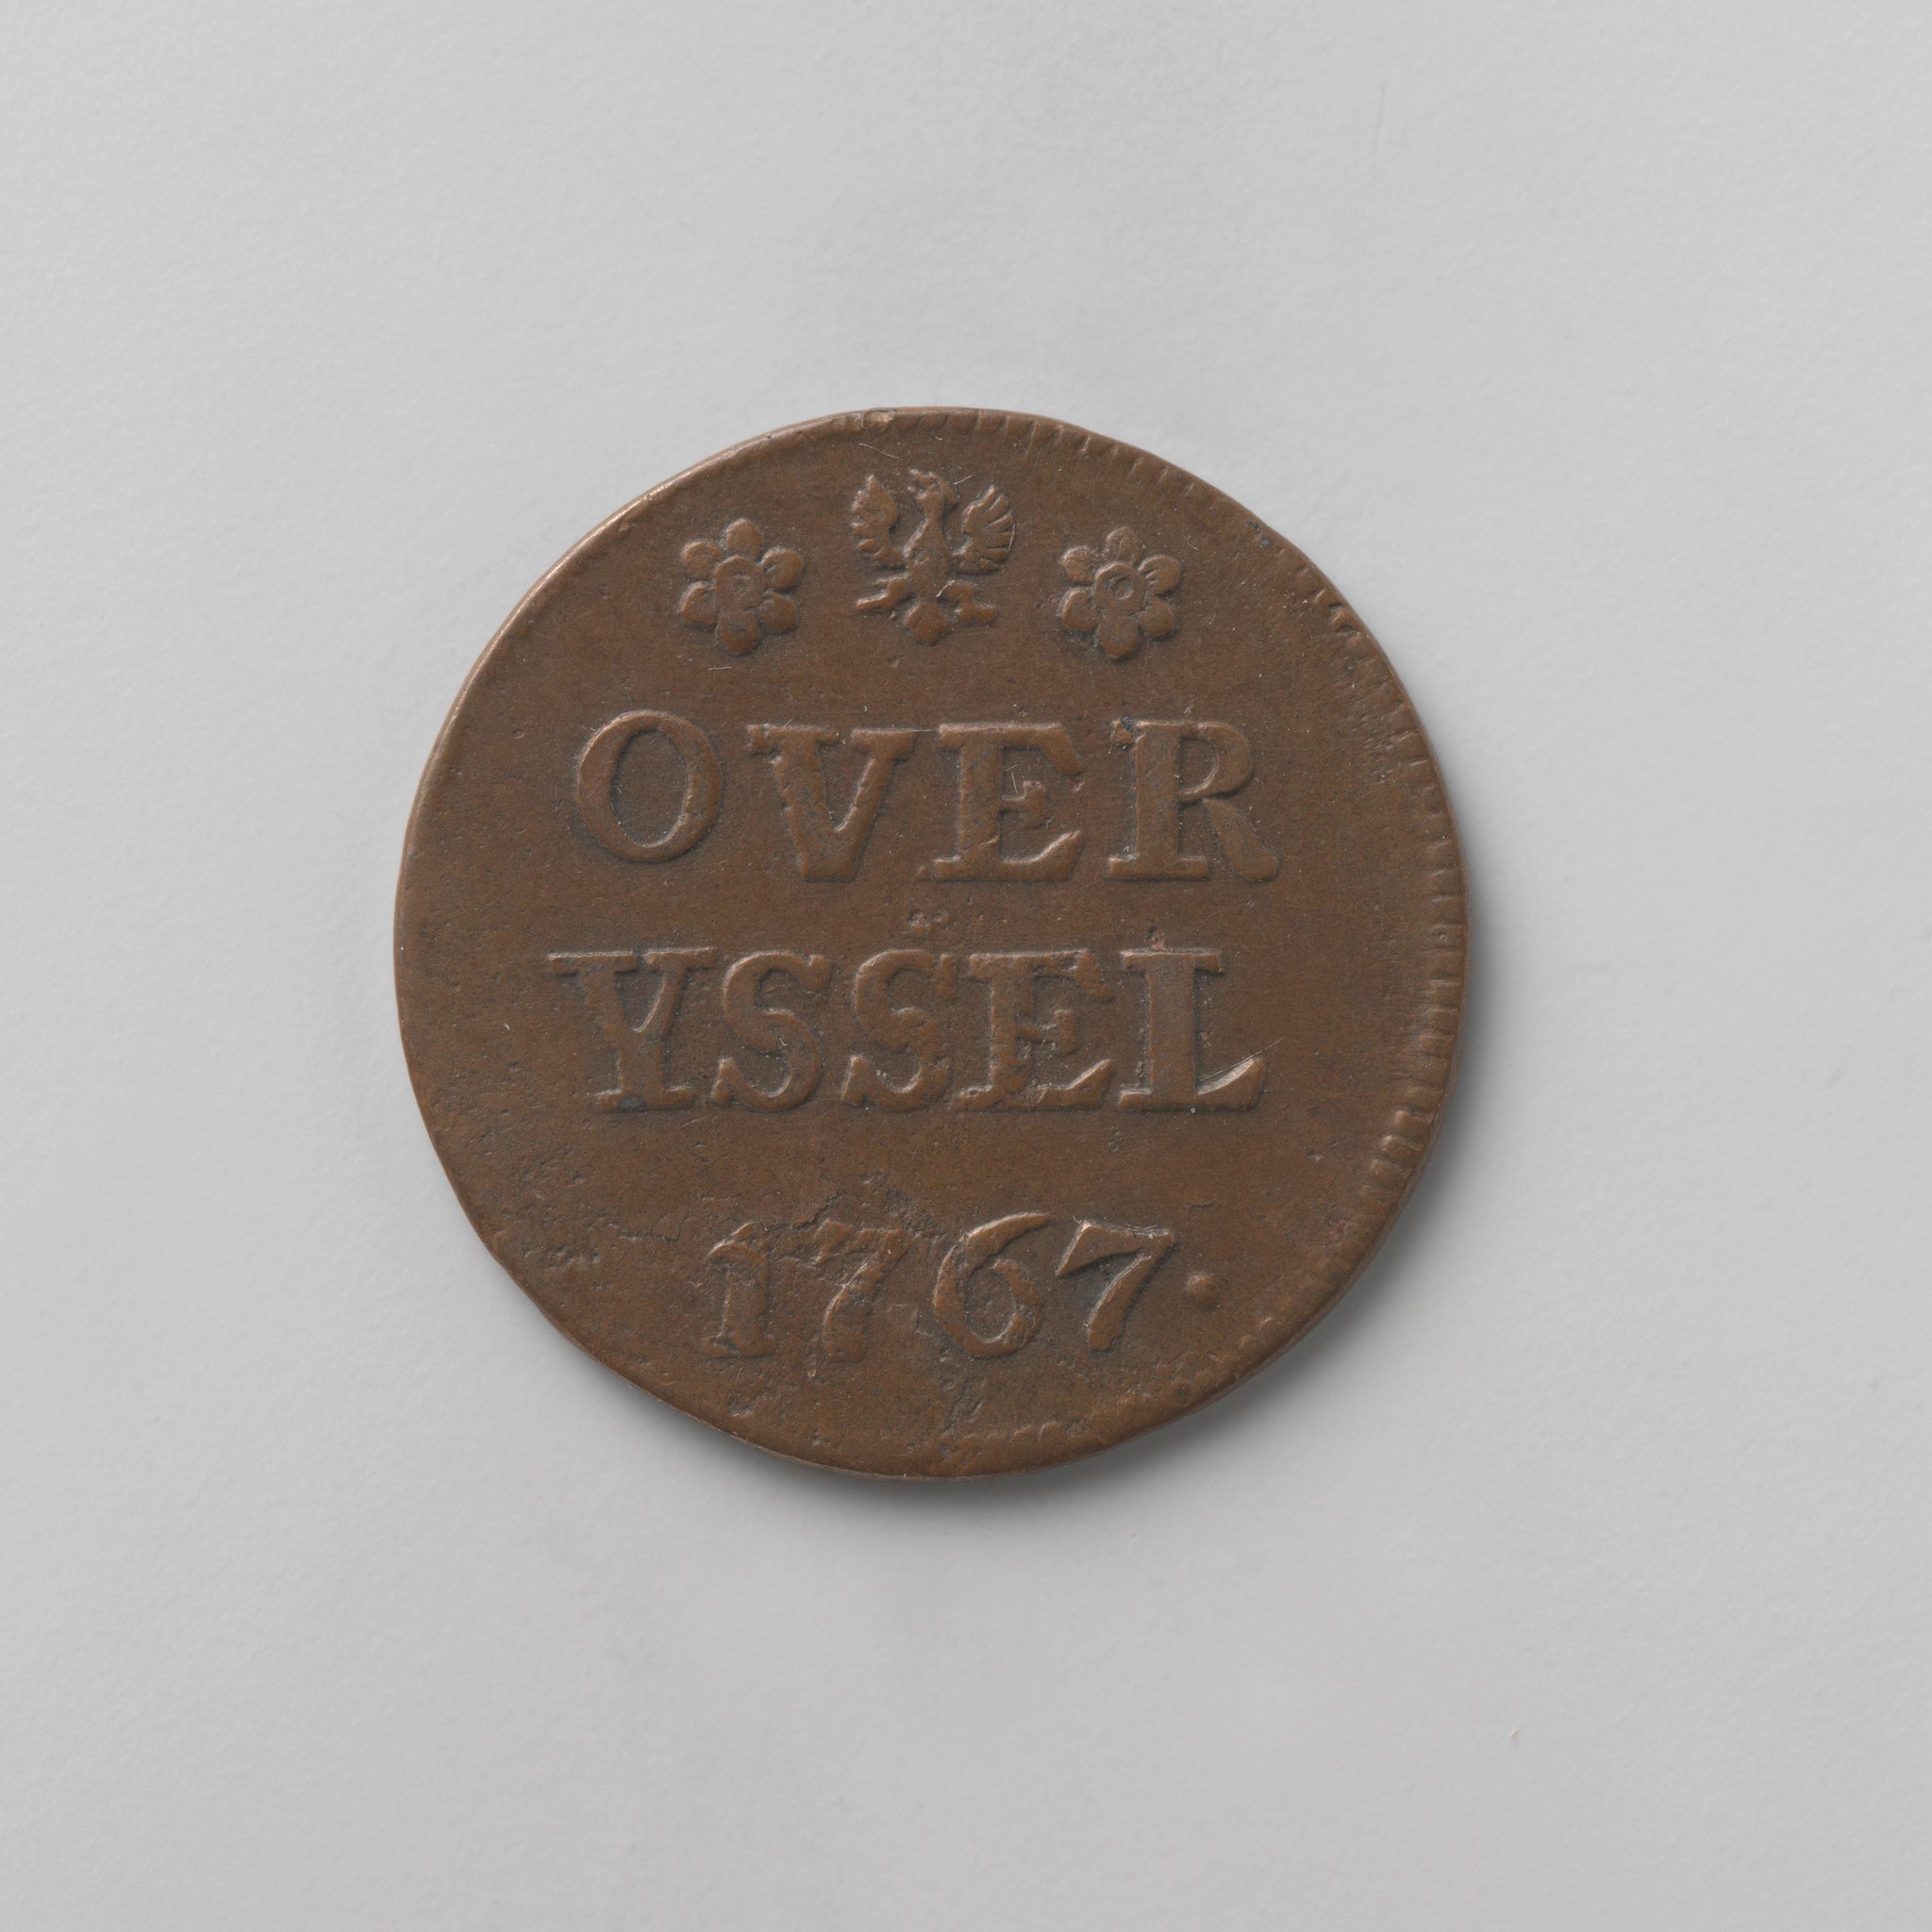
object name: coin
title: Overijssel, duit, 1767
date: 1767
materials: copper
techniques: striking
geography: kampen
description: Koperen munt. Voorzijde: tussen wapenspreuk gekroond provinciaal wapenschild. Keerzijde: tweeregelig opschrift, waarboven muntmeesterteken en waaronder jaartal.